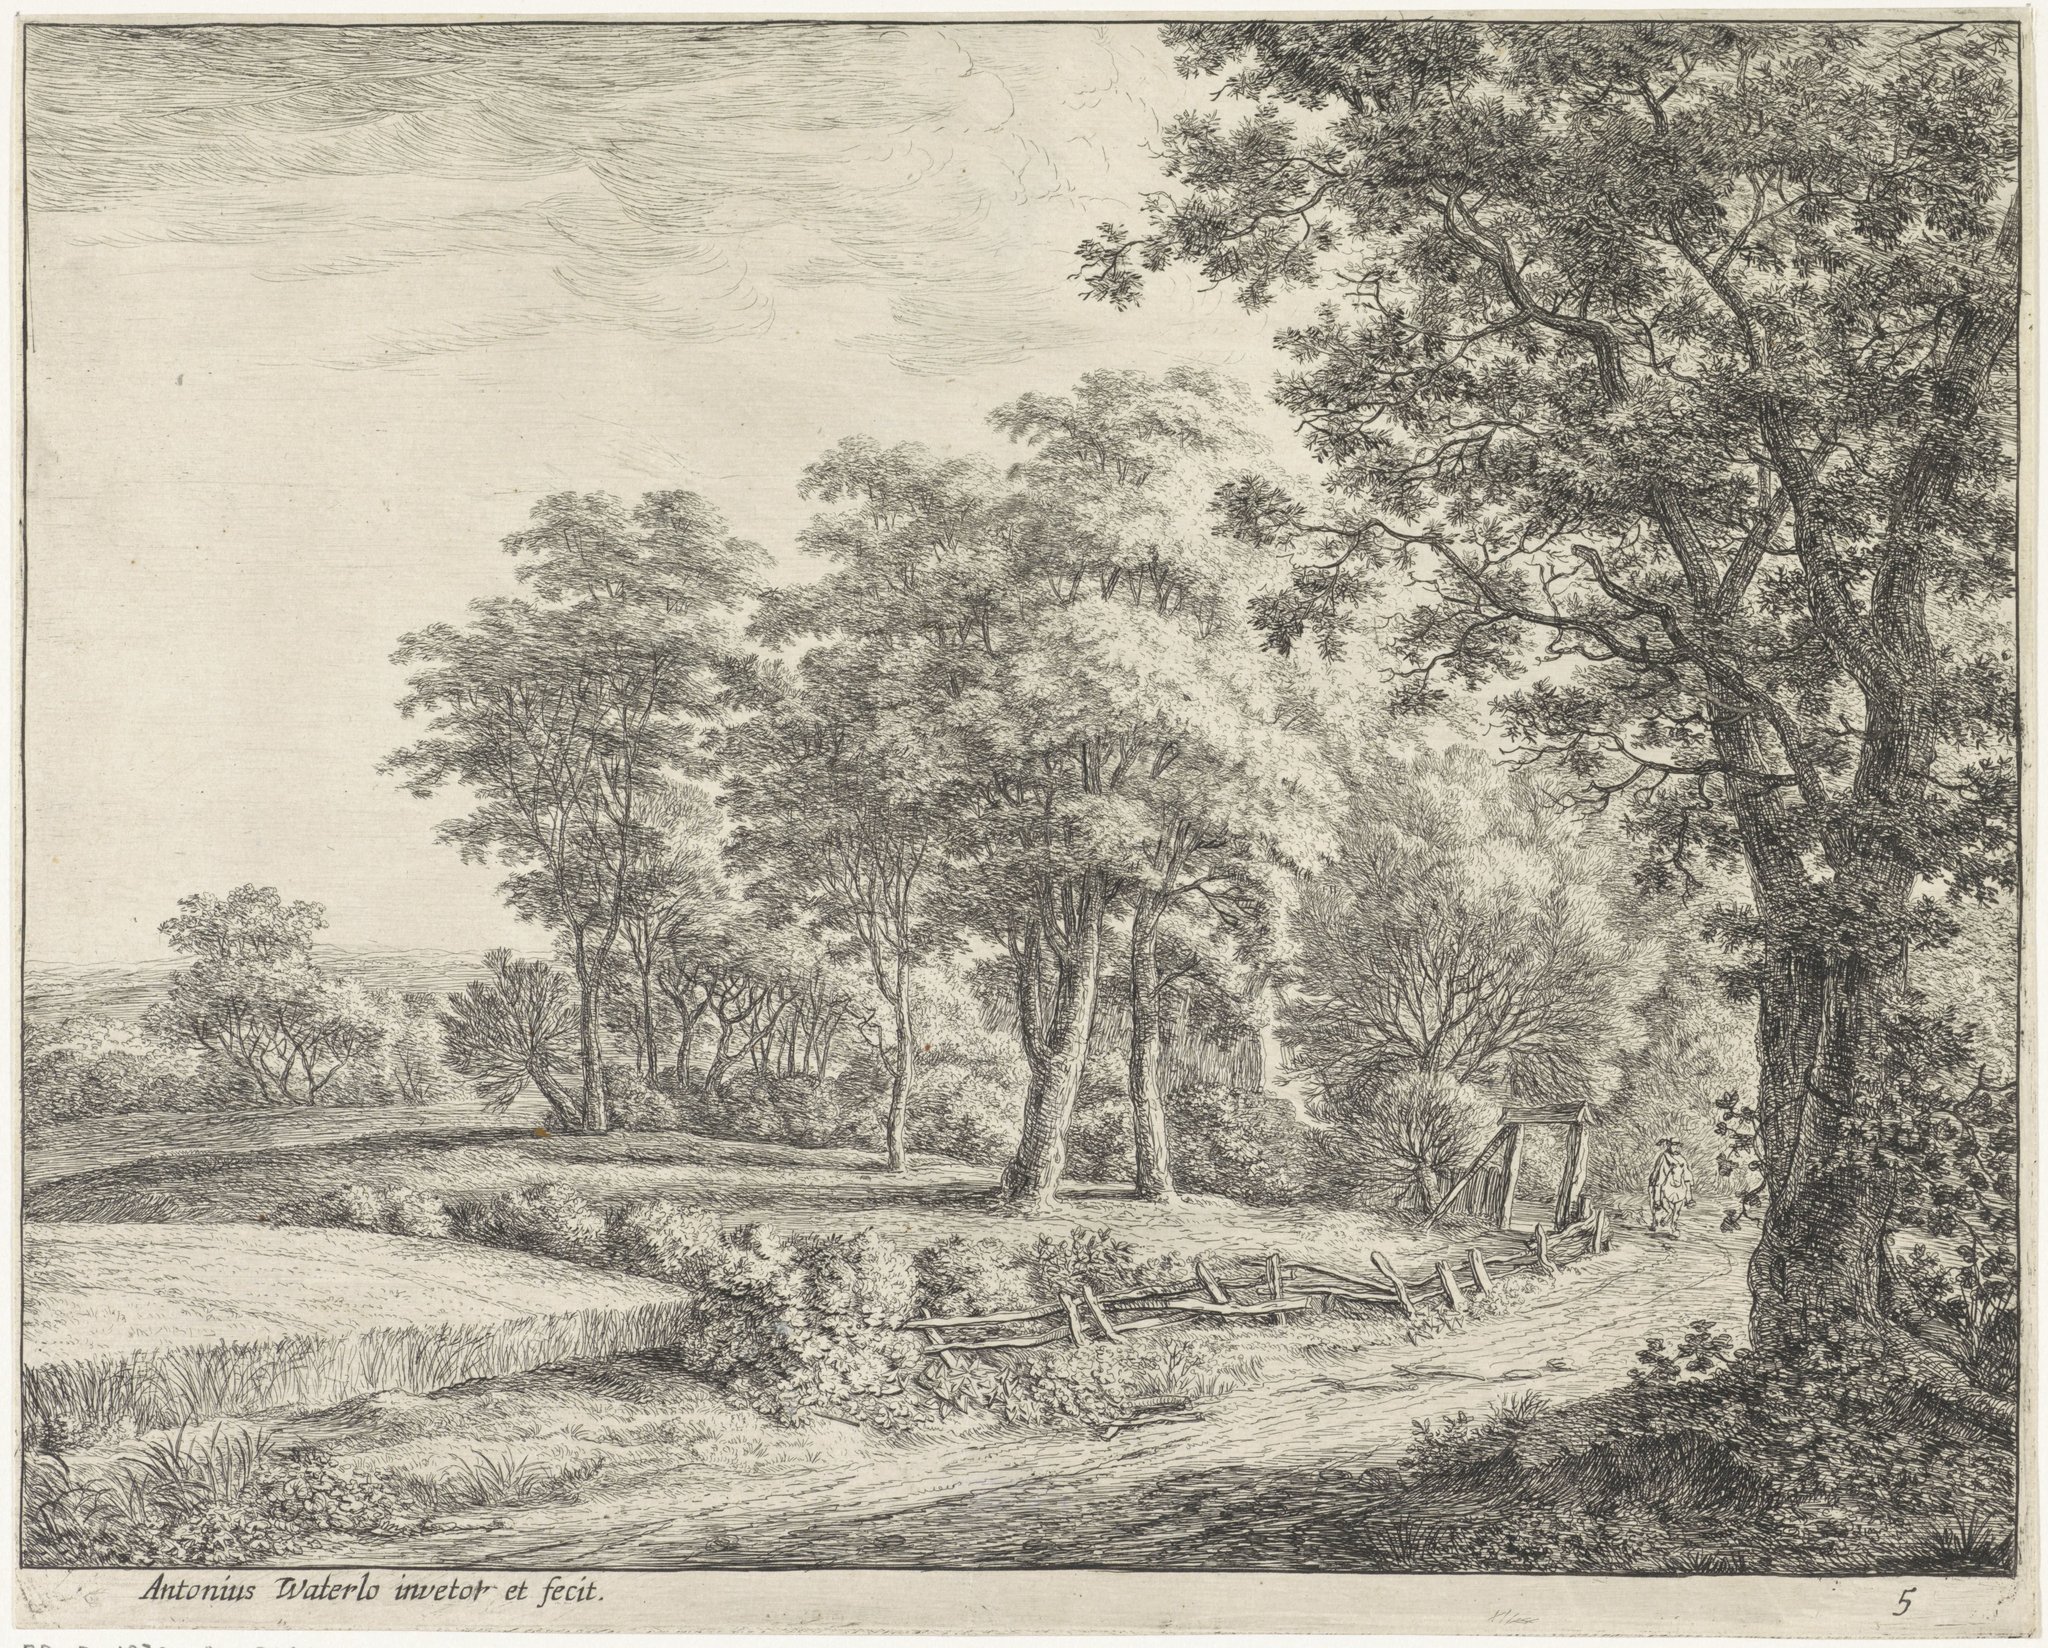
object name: print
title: Grote landschappen, serie B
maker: anthonie waterloo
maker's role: draughtsman, painter, print maker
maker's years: 1609-1690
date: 1630-1663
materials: paper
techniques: etching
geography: amsterdam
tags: riding a horse, ass, or mule; rider, horseman, fence, wall, paling, forest path or lane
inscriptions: collector's mark: Lugt 2228, inscription: ‘Seltener Abdruck vor den vielen Grabstichelretouchen...hinzugekommenen Grashalmen’, collector's mark: Lugt 270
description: Een ruiter rijdt op een bospad. Links is een vervallen, houten hek met een houten poort te zien.